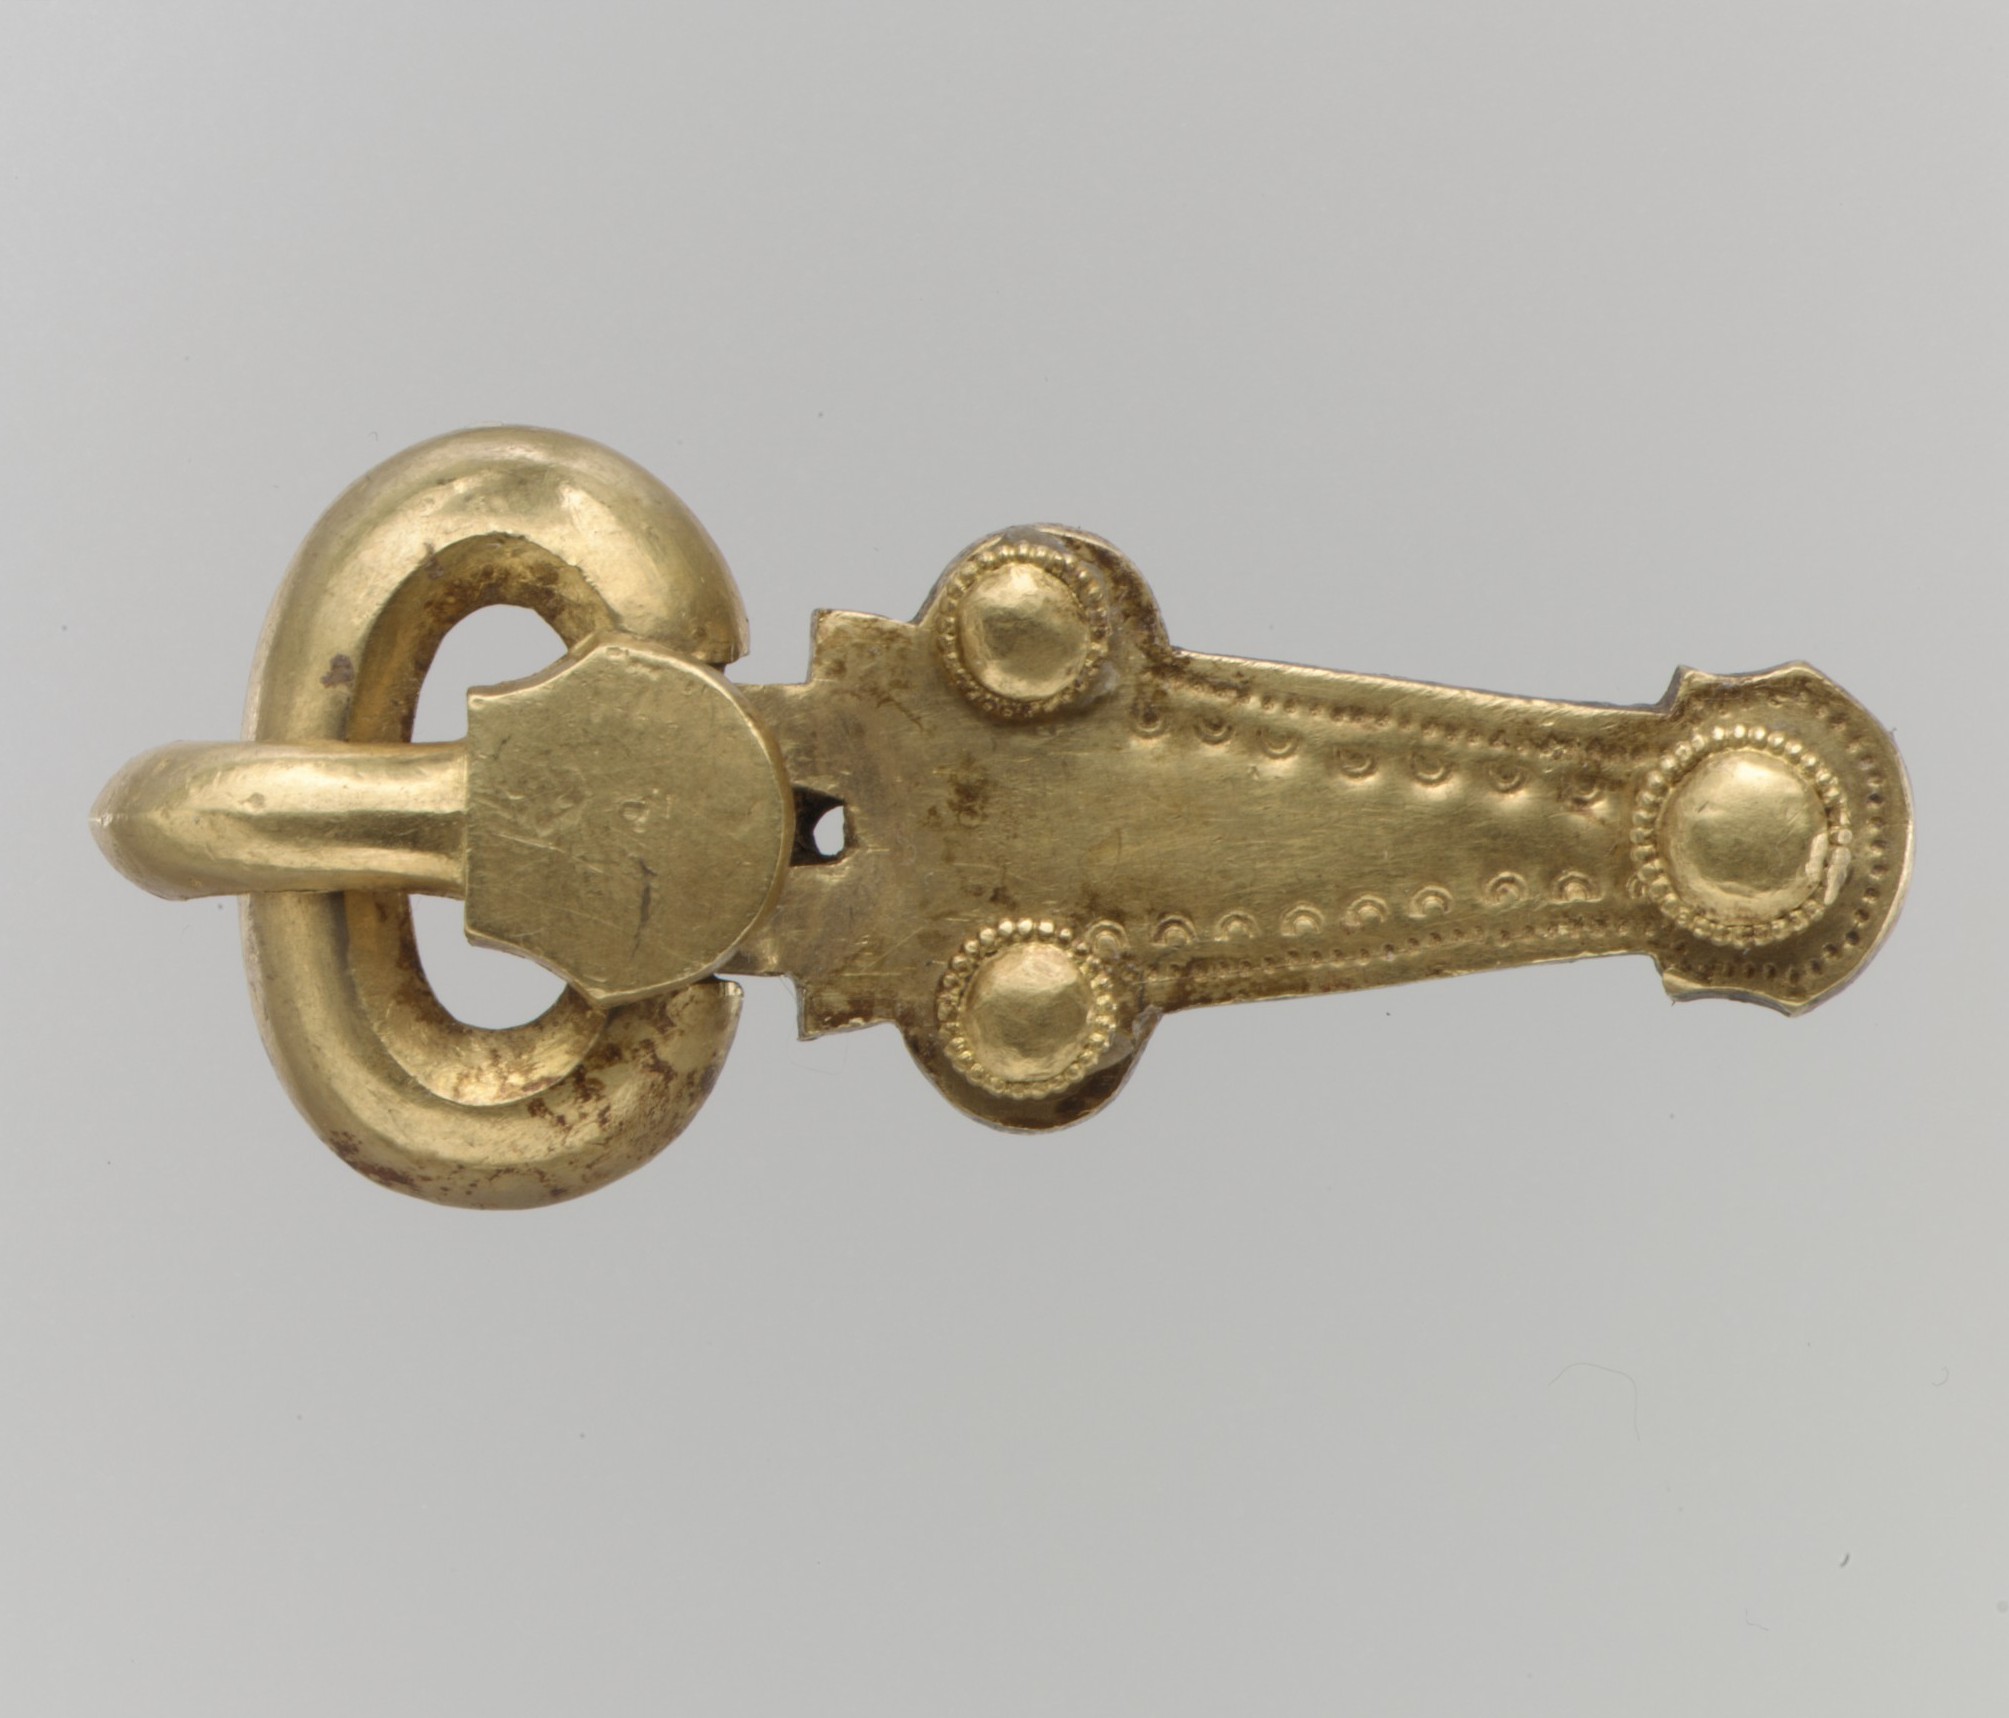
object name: shoe buckle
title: Gold Shoe Buckle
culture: langobardic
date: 600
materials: gold, silver